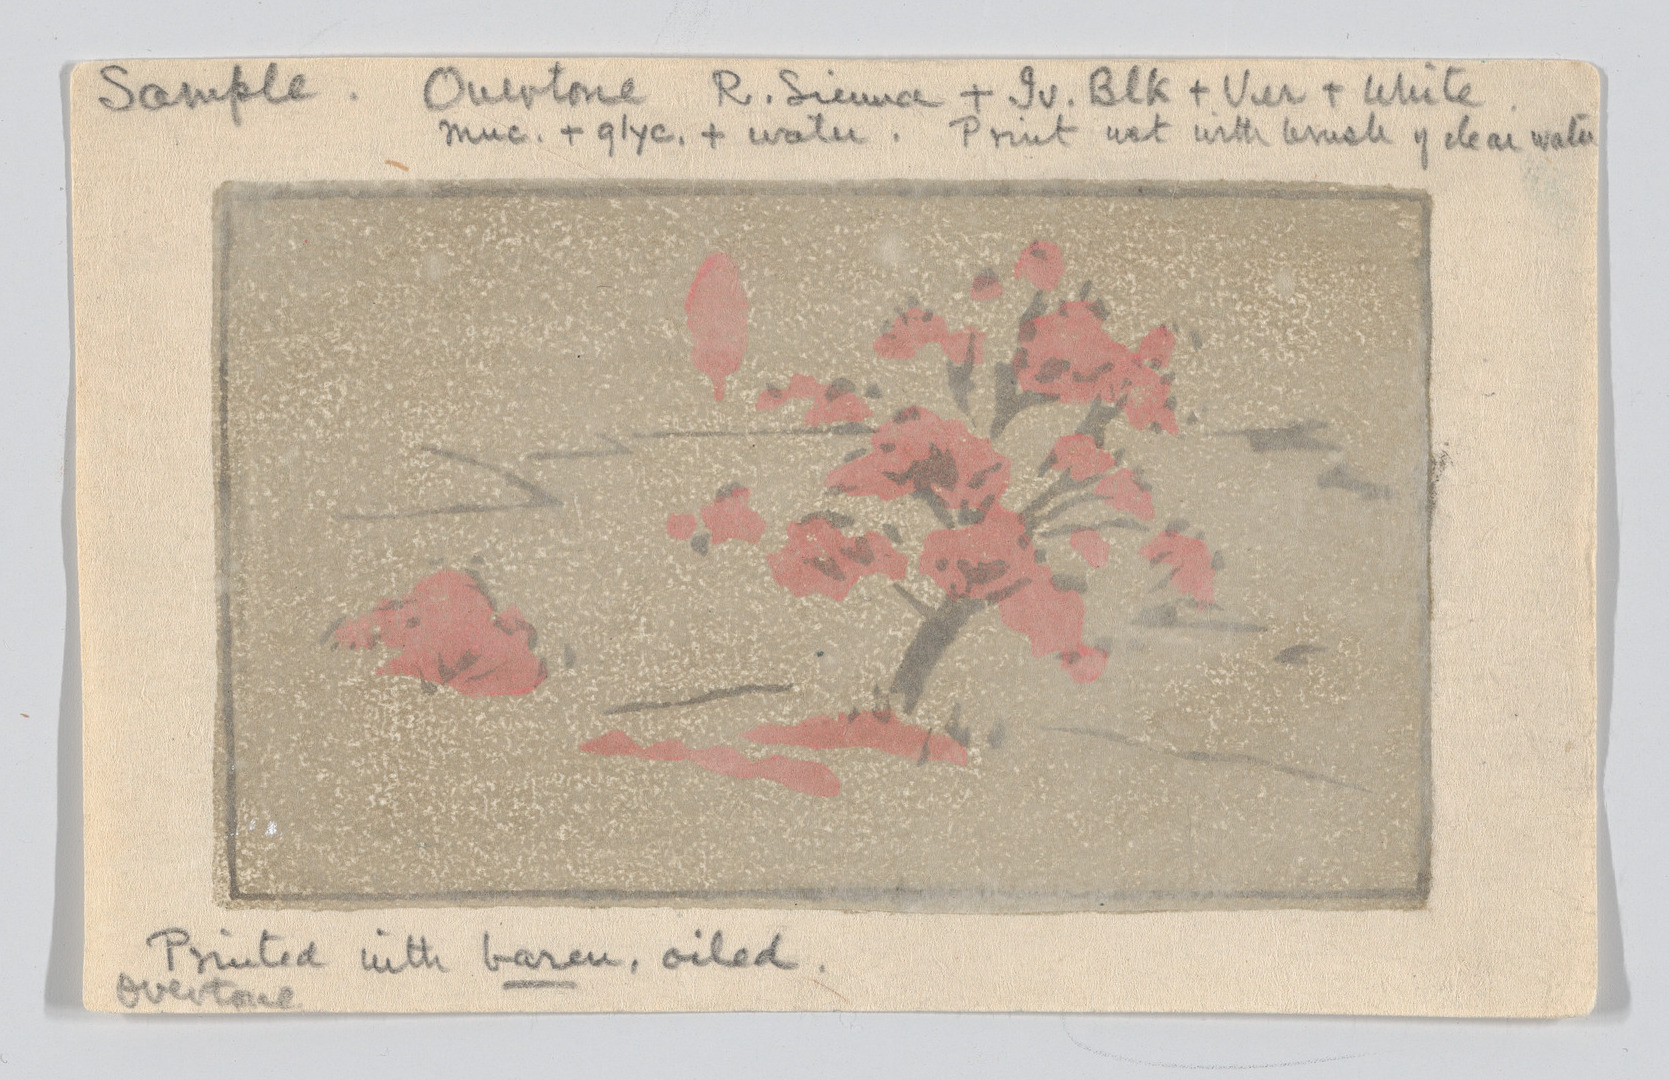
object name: woodcut, print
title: Nabby's Point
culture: american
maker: arthur wesley dow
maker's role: artist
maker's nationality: american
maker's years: 1857-1922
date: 1913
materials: paper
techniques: woodcut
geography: united states